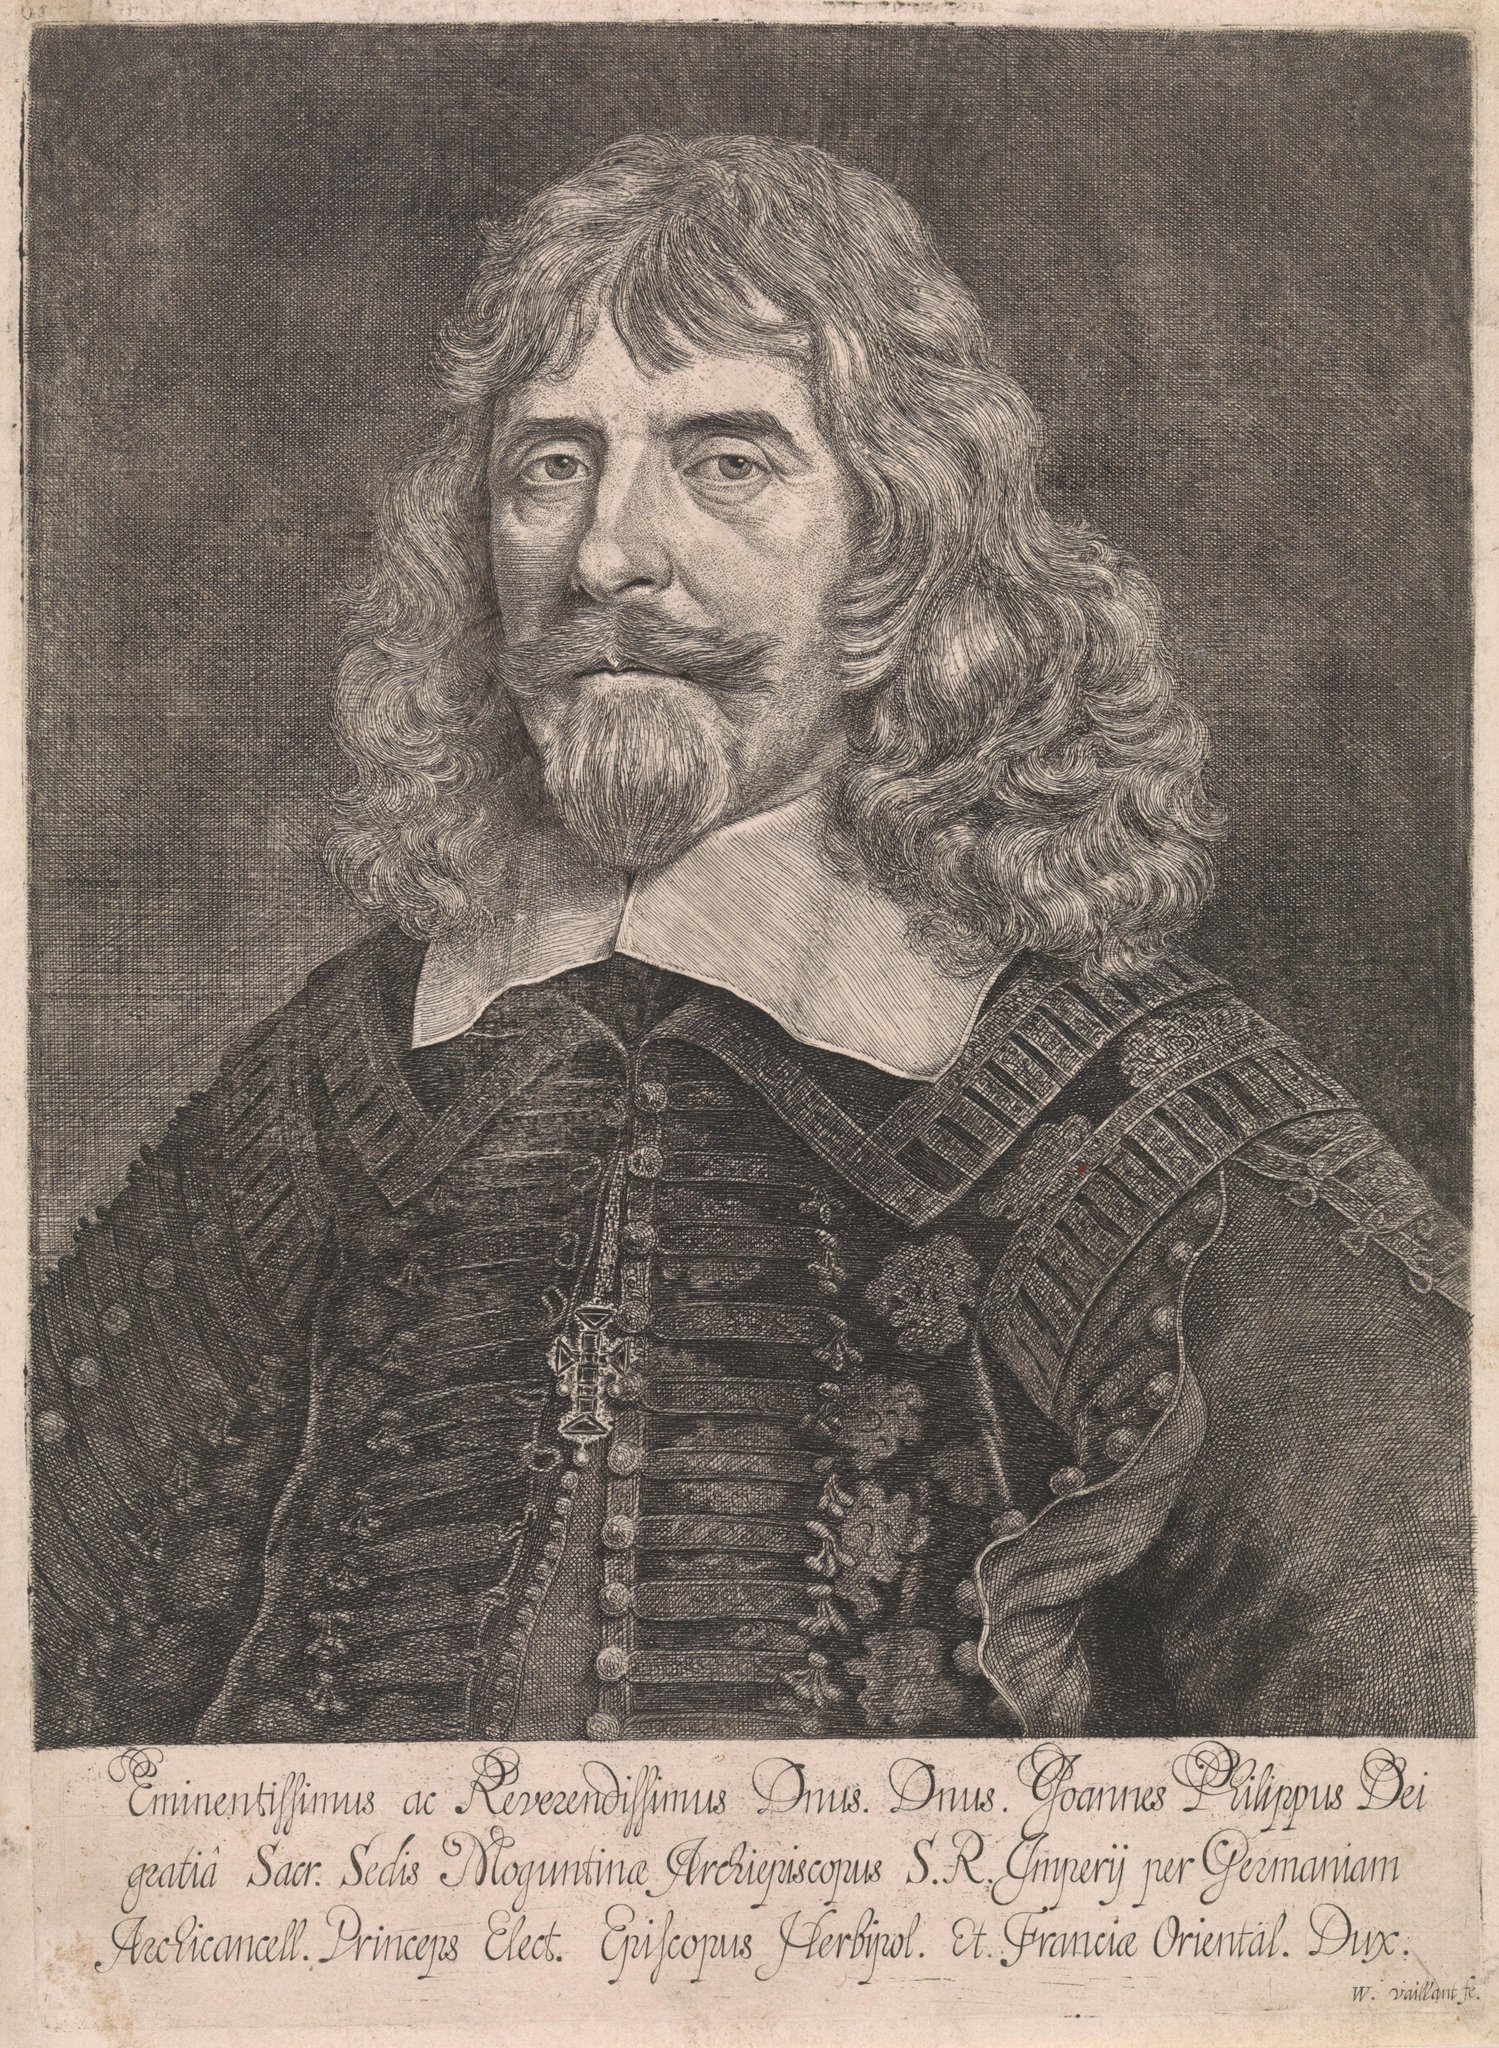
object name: print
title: Portret van Johann Philipp von Schönborn, aartsbisschop van Mainz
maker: wallerant vaillant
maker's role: draughtsman, painter, print maker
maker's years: 1623-1677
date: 1658-1677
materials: paper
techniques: etching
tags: hessen, würzburg, bisschop, johann philipp von schönborn (aartsbisschop van mainz)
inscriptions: collector's mark: Lugt 2228